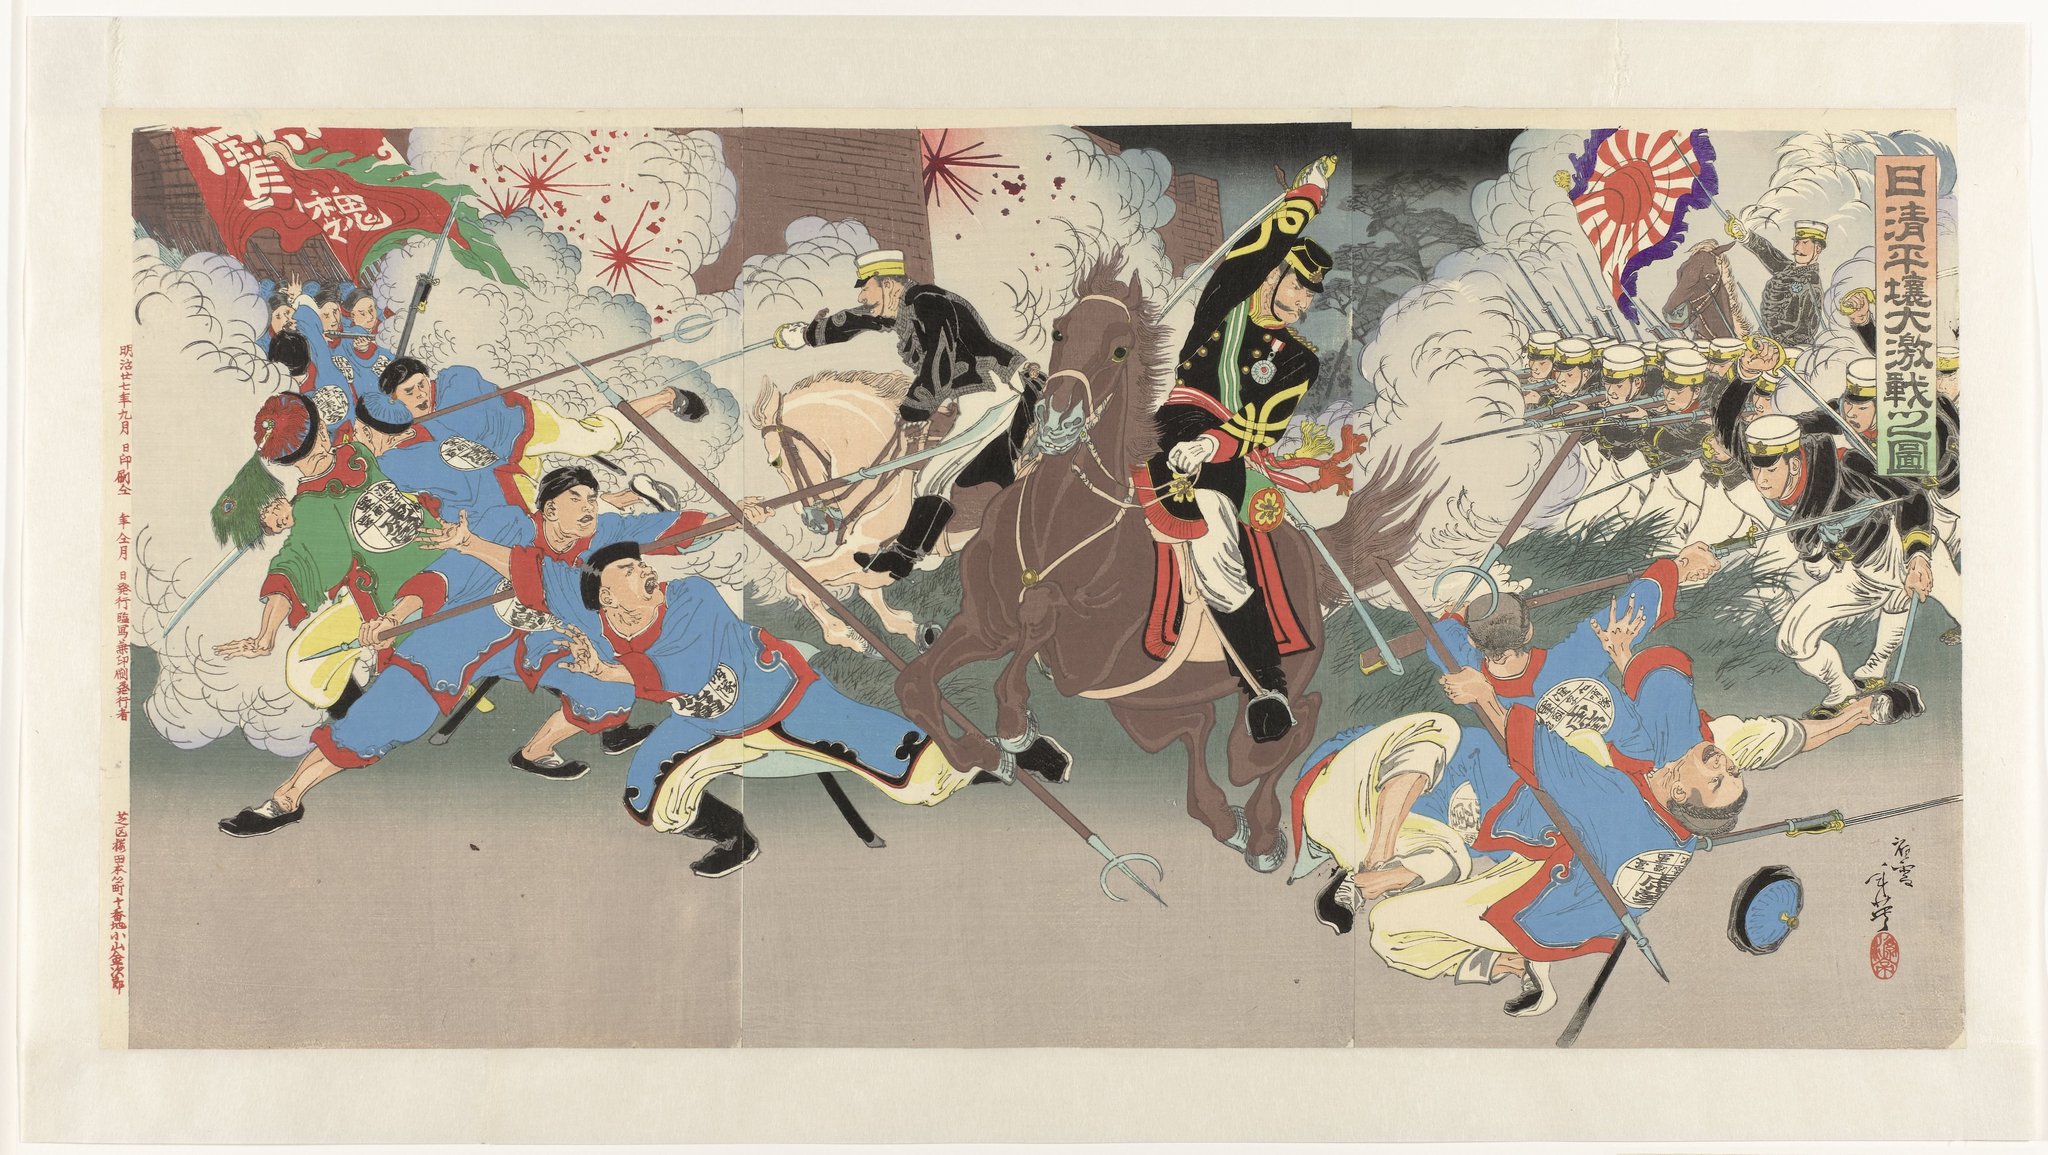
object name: triptych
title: Nisshin Heijô daigekisen no zu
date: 1894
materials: paper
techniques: woodcut, polish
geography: japan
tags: riding a horse, ass, or mule; rider, horseman, battle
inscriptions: label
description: Japanse troepen vallen Koreaanse soldaten aan bij de ommuurde stad Pyongyang. Deze strijd vond plaats in september 1894, ten tijde van de Eerste Chinees-Japanse Oorlog (1894-1895).